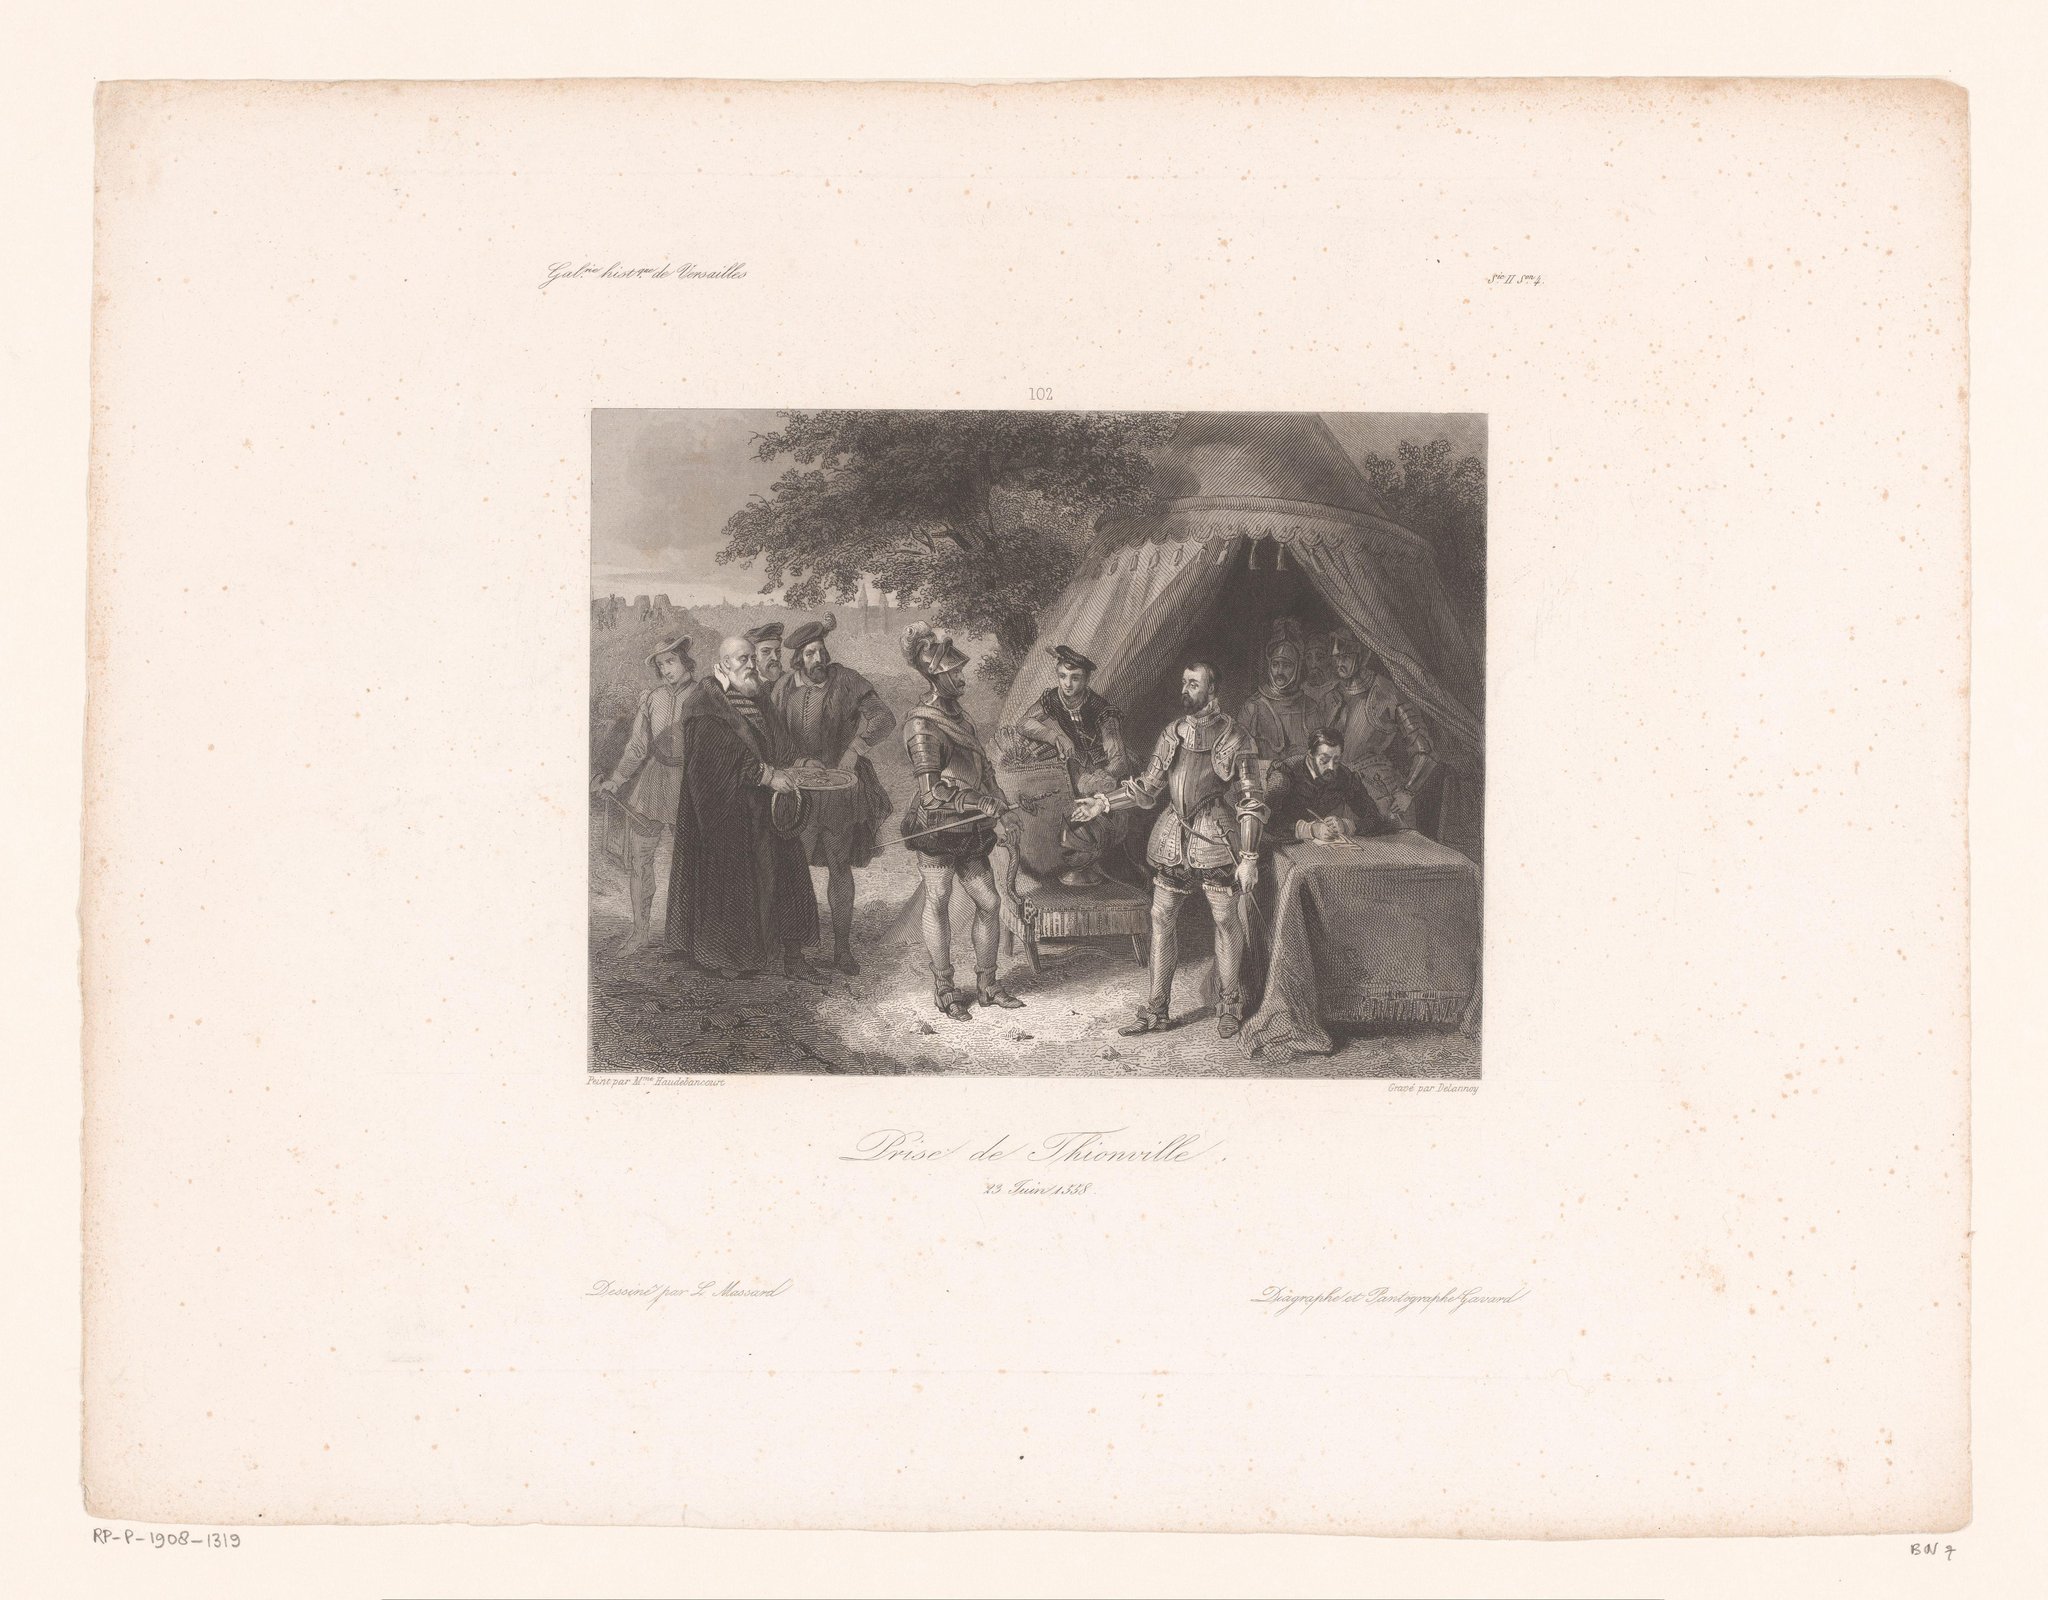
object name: print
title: Beleg van Thionville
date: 1838-1841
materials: paper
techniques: engraving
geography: france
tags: siege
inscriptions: collector's mark: Lugt 2228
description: Prent uit: s.n. Galeries historiques de Versailles. Parijs: Charles Gavard, 1838-1841.